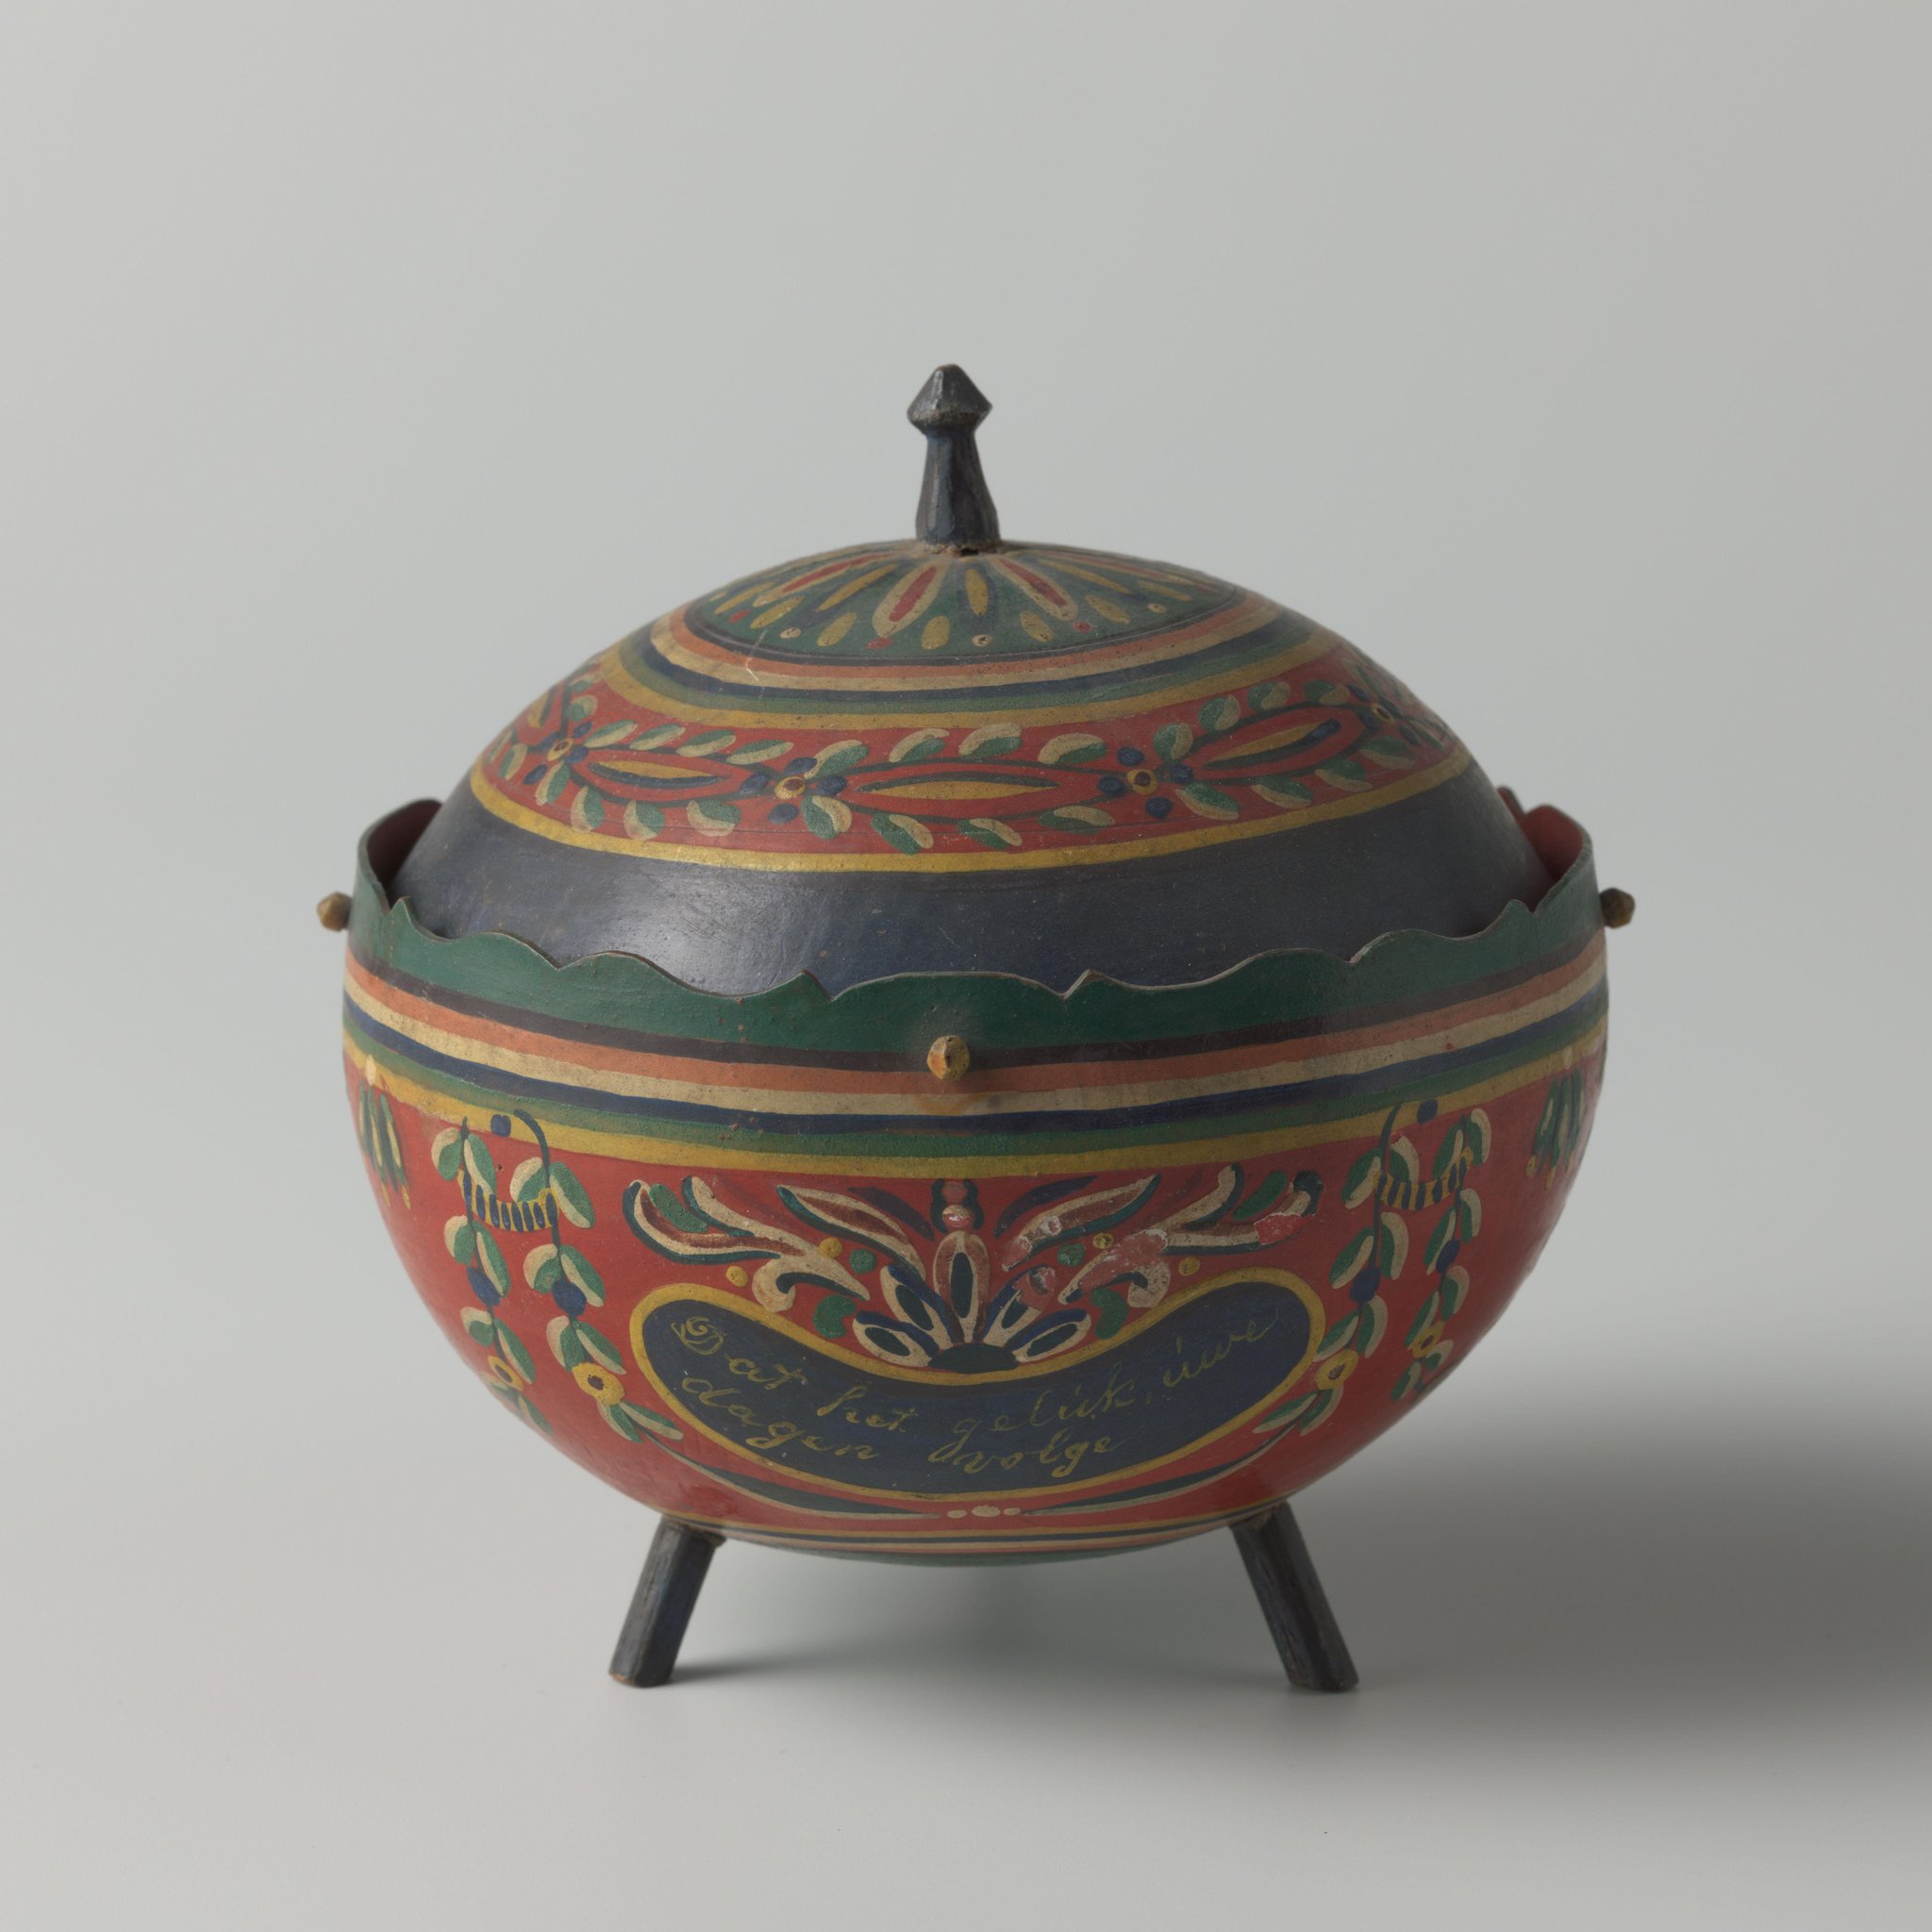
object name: lid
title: Deksel van doos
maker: Anonymous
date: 1780-1850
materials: paint, wood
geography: northern netherlands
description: Kleurig geschilderd deksel horend bij een rond doosje.